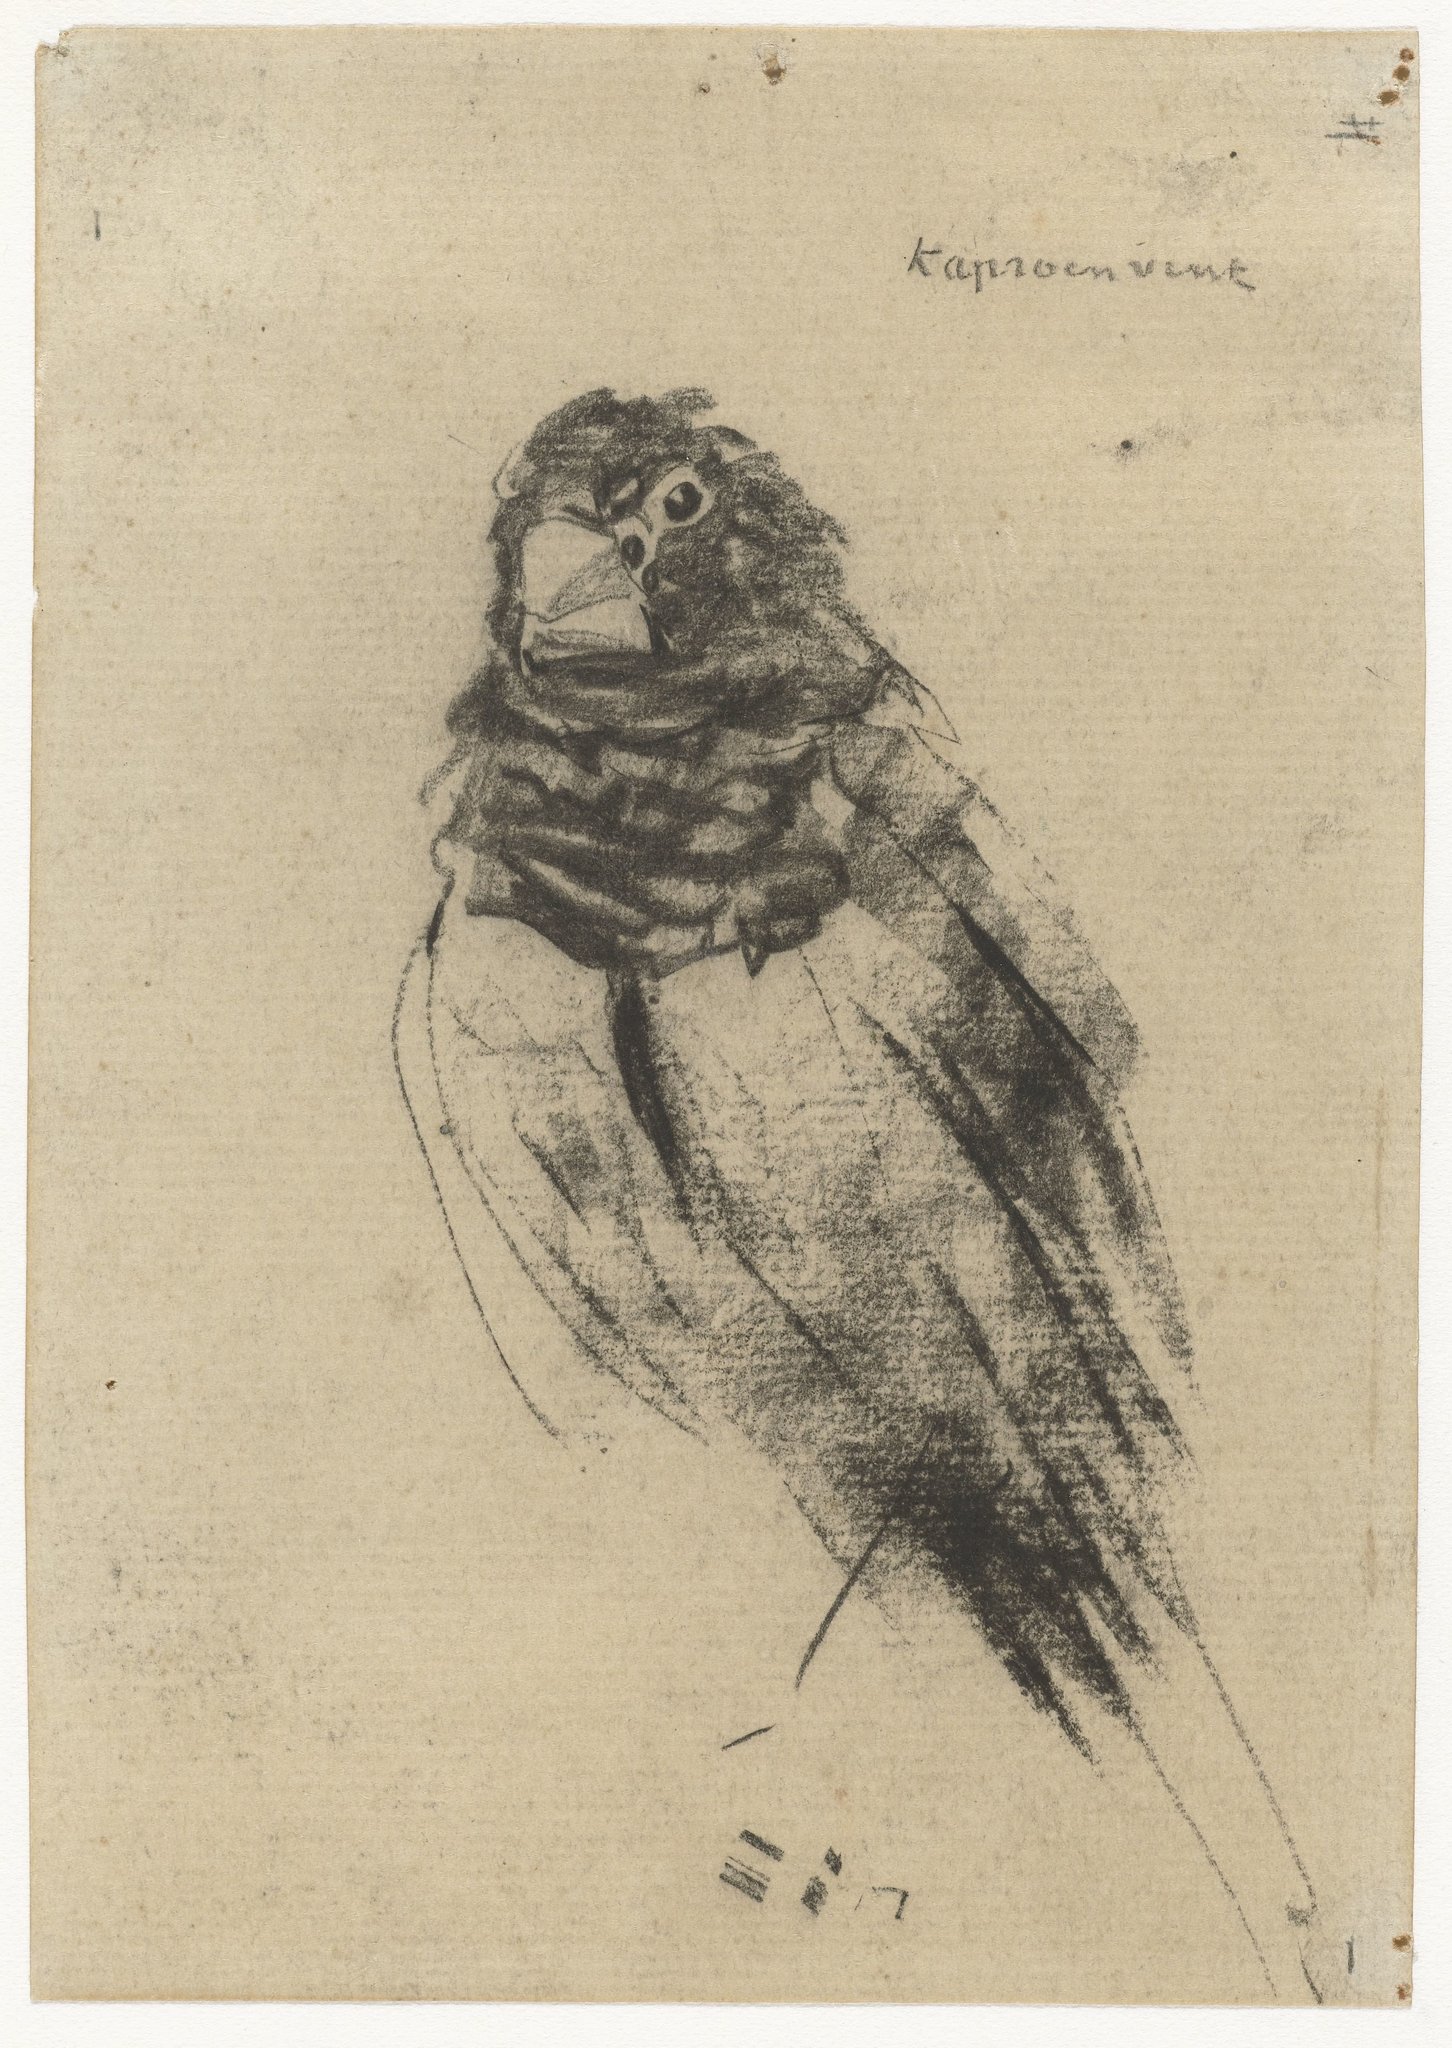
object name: drawing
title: Kaproenvink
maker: gerrit willem dijsselhof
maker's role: designer, draughtsman, print maker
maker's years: 1866-1924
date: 1876-1924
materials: chalk, paper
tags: song-birds: finch